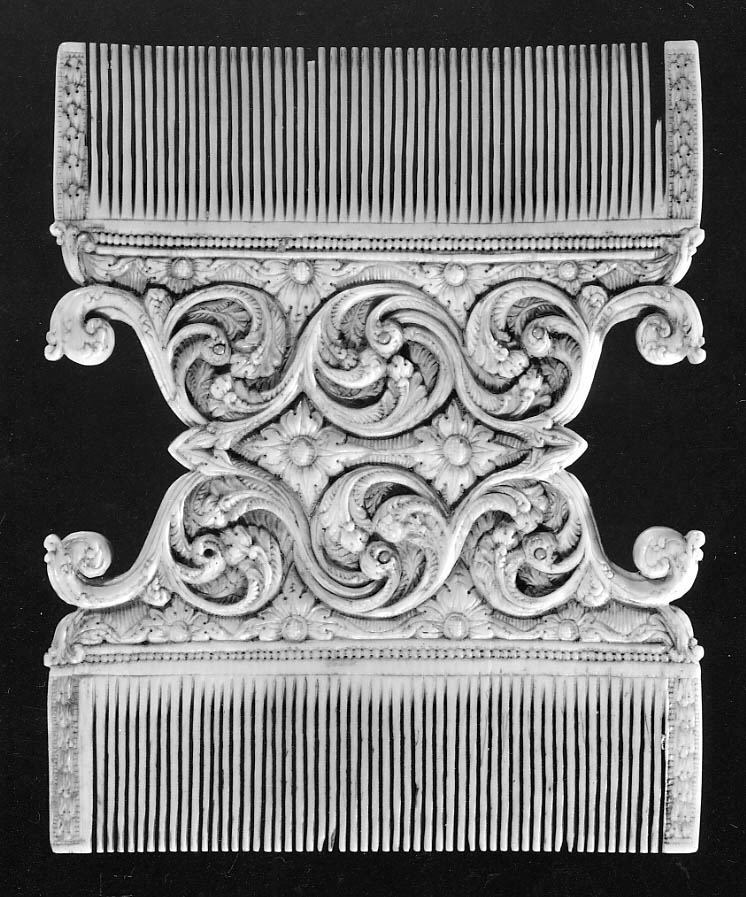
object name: double sided comb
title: Double-Sided Comb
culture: sri lankan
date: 1701-1800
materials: ivory